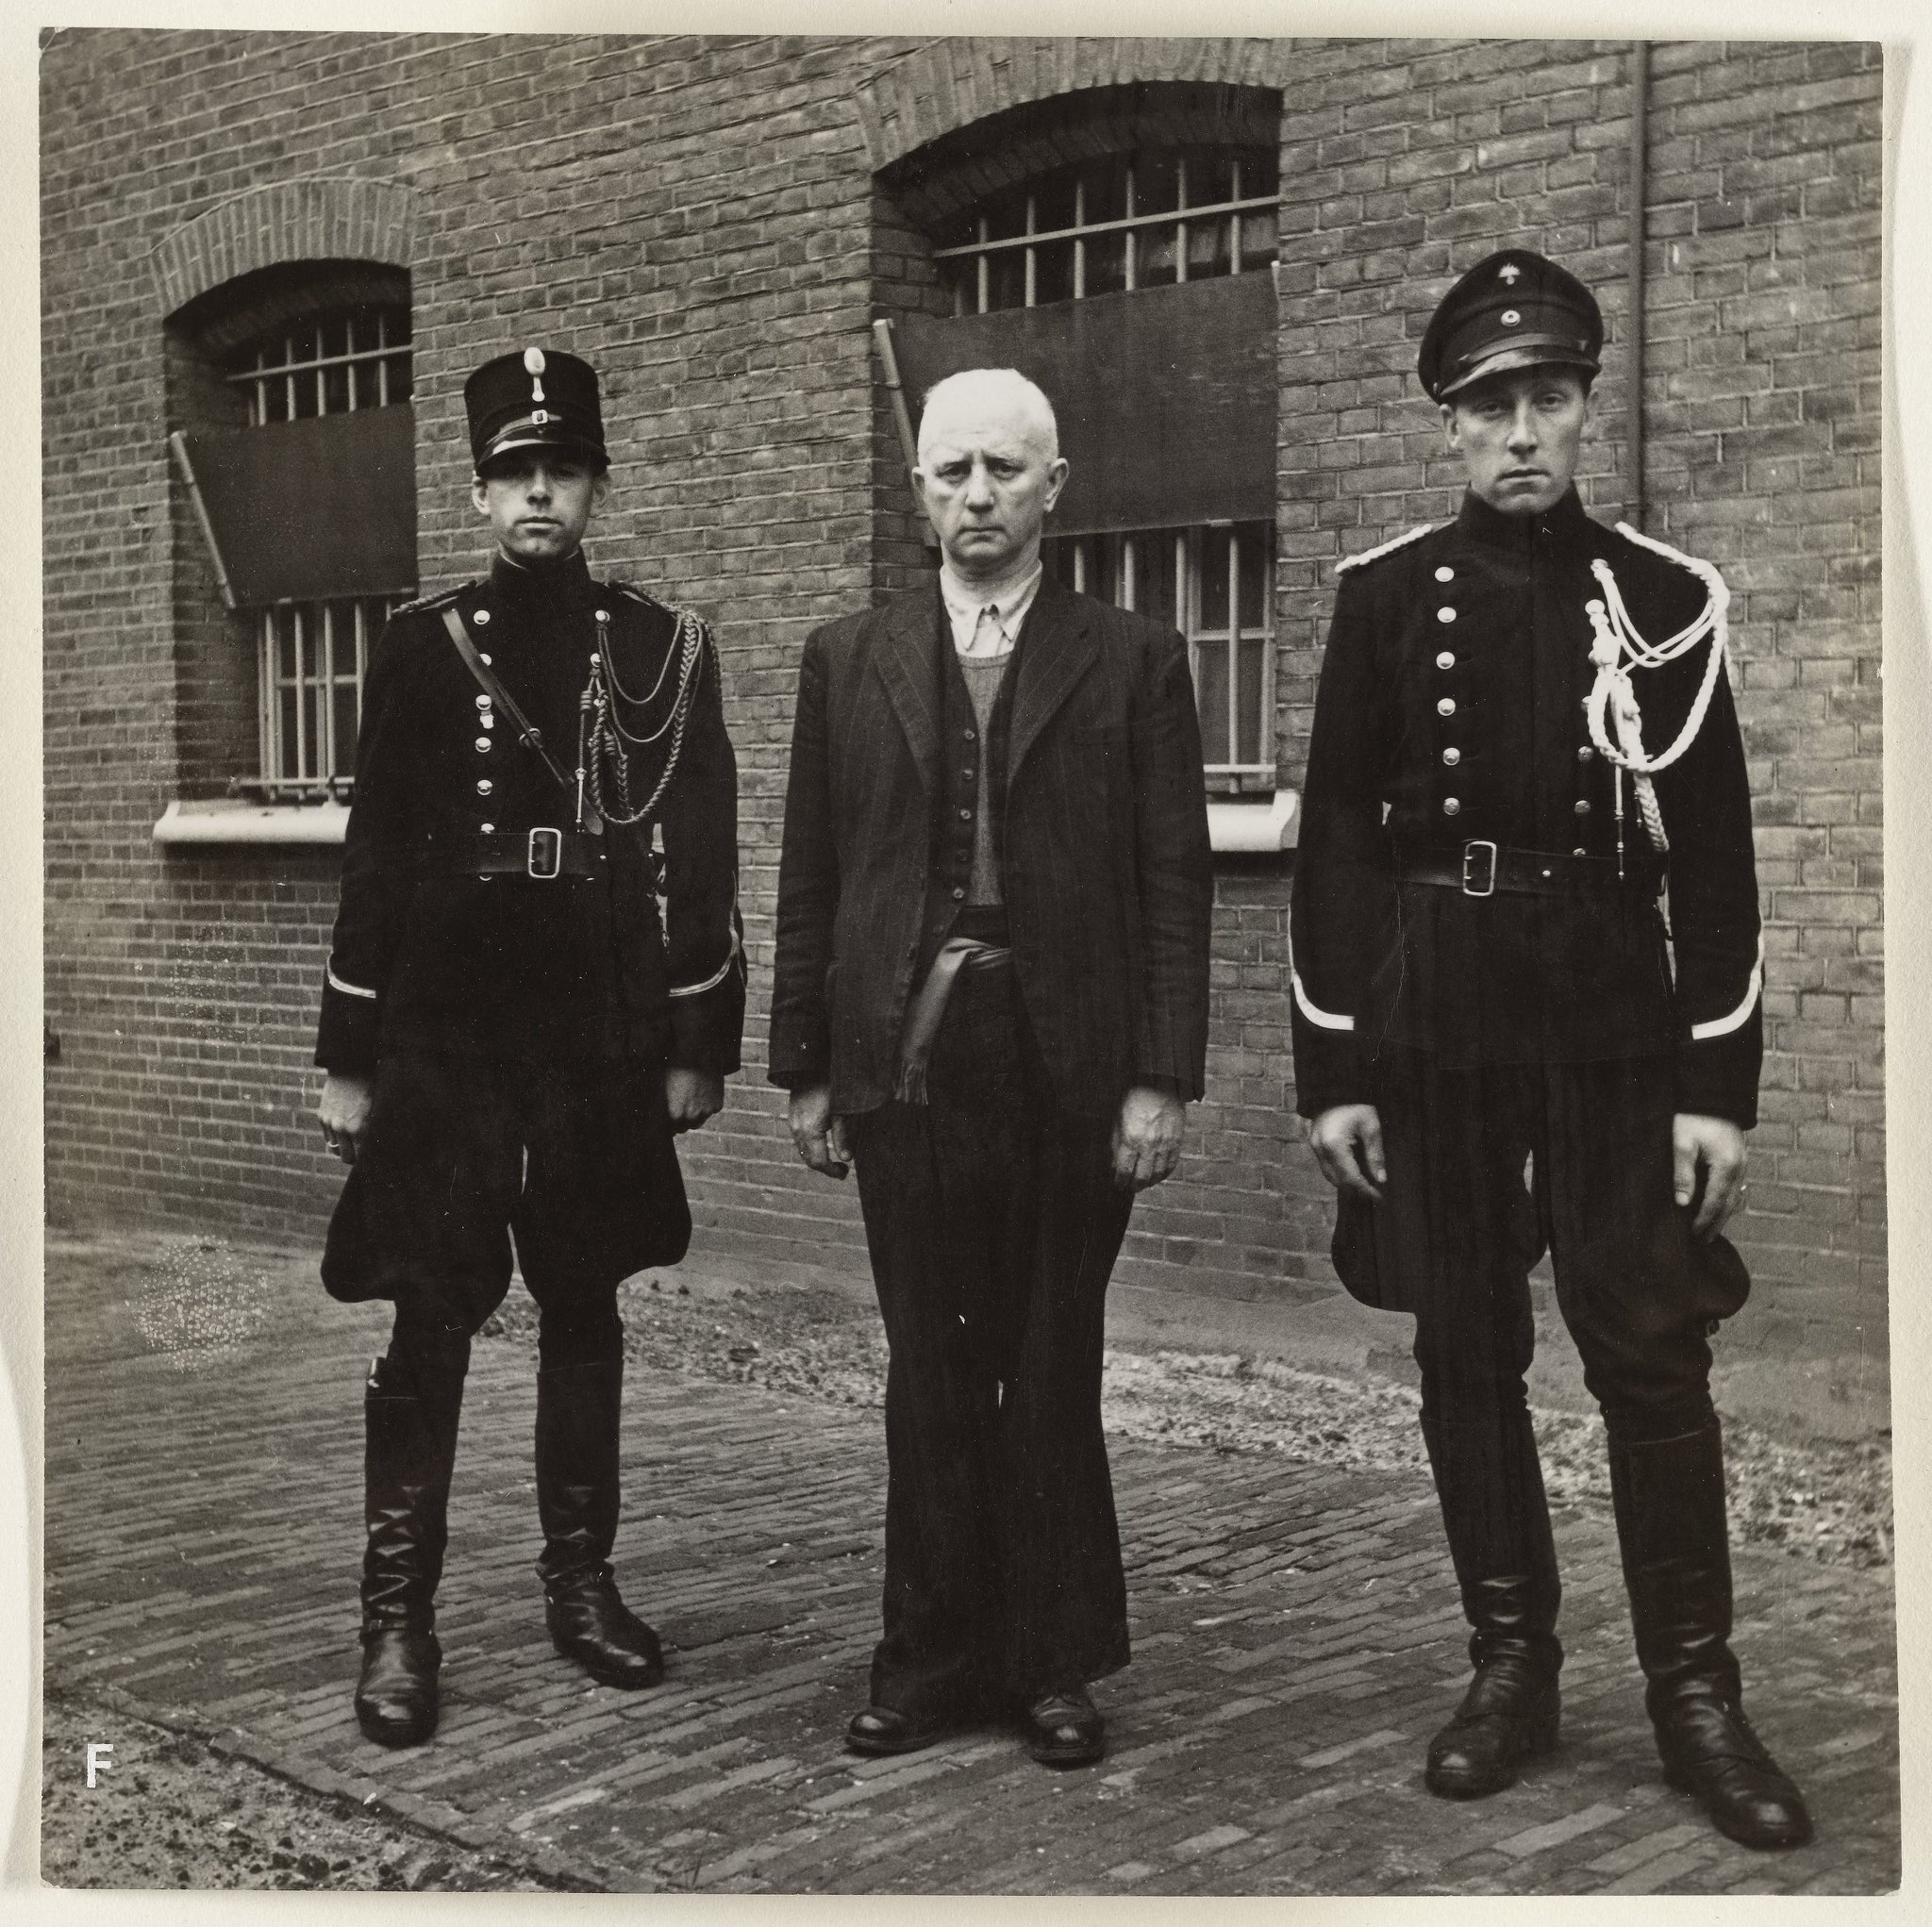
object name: photograph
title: Max Blokzijl kort na zijn arrestatie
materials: photographic support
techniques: photography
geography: the hague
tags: max blokzijl, the hague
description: Max Blokzijl was bekend van zijn vele Nationaal-socialistische radiopraatjes. Het proces vond plaats in het paleis aan de Kneuterdijk. Blokzijl werd, als eerste collaborateur, ter dood veroordeeld en op 16 maart 1946 gefusilleerd. [Baruch, Jet, 2006].